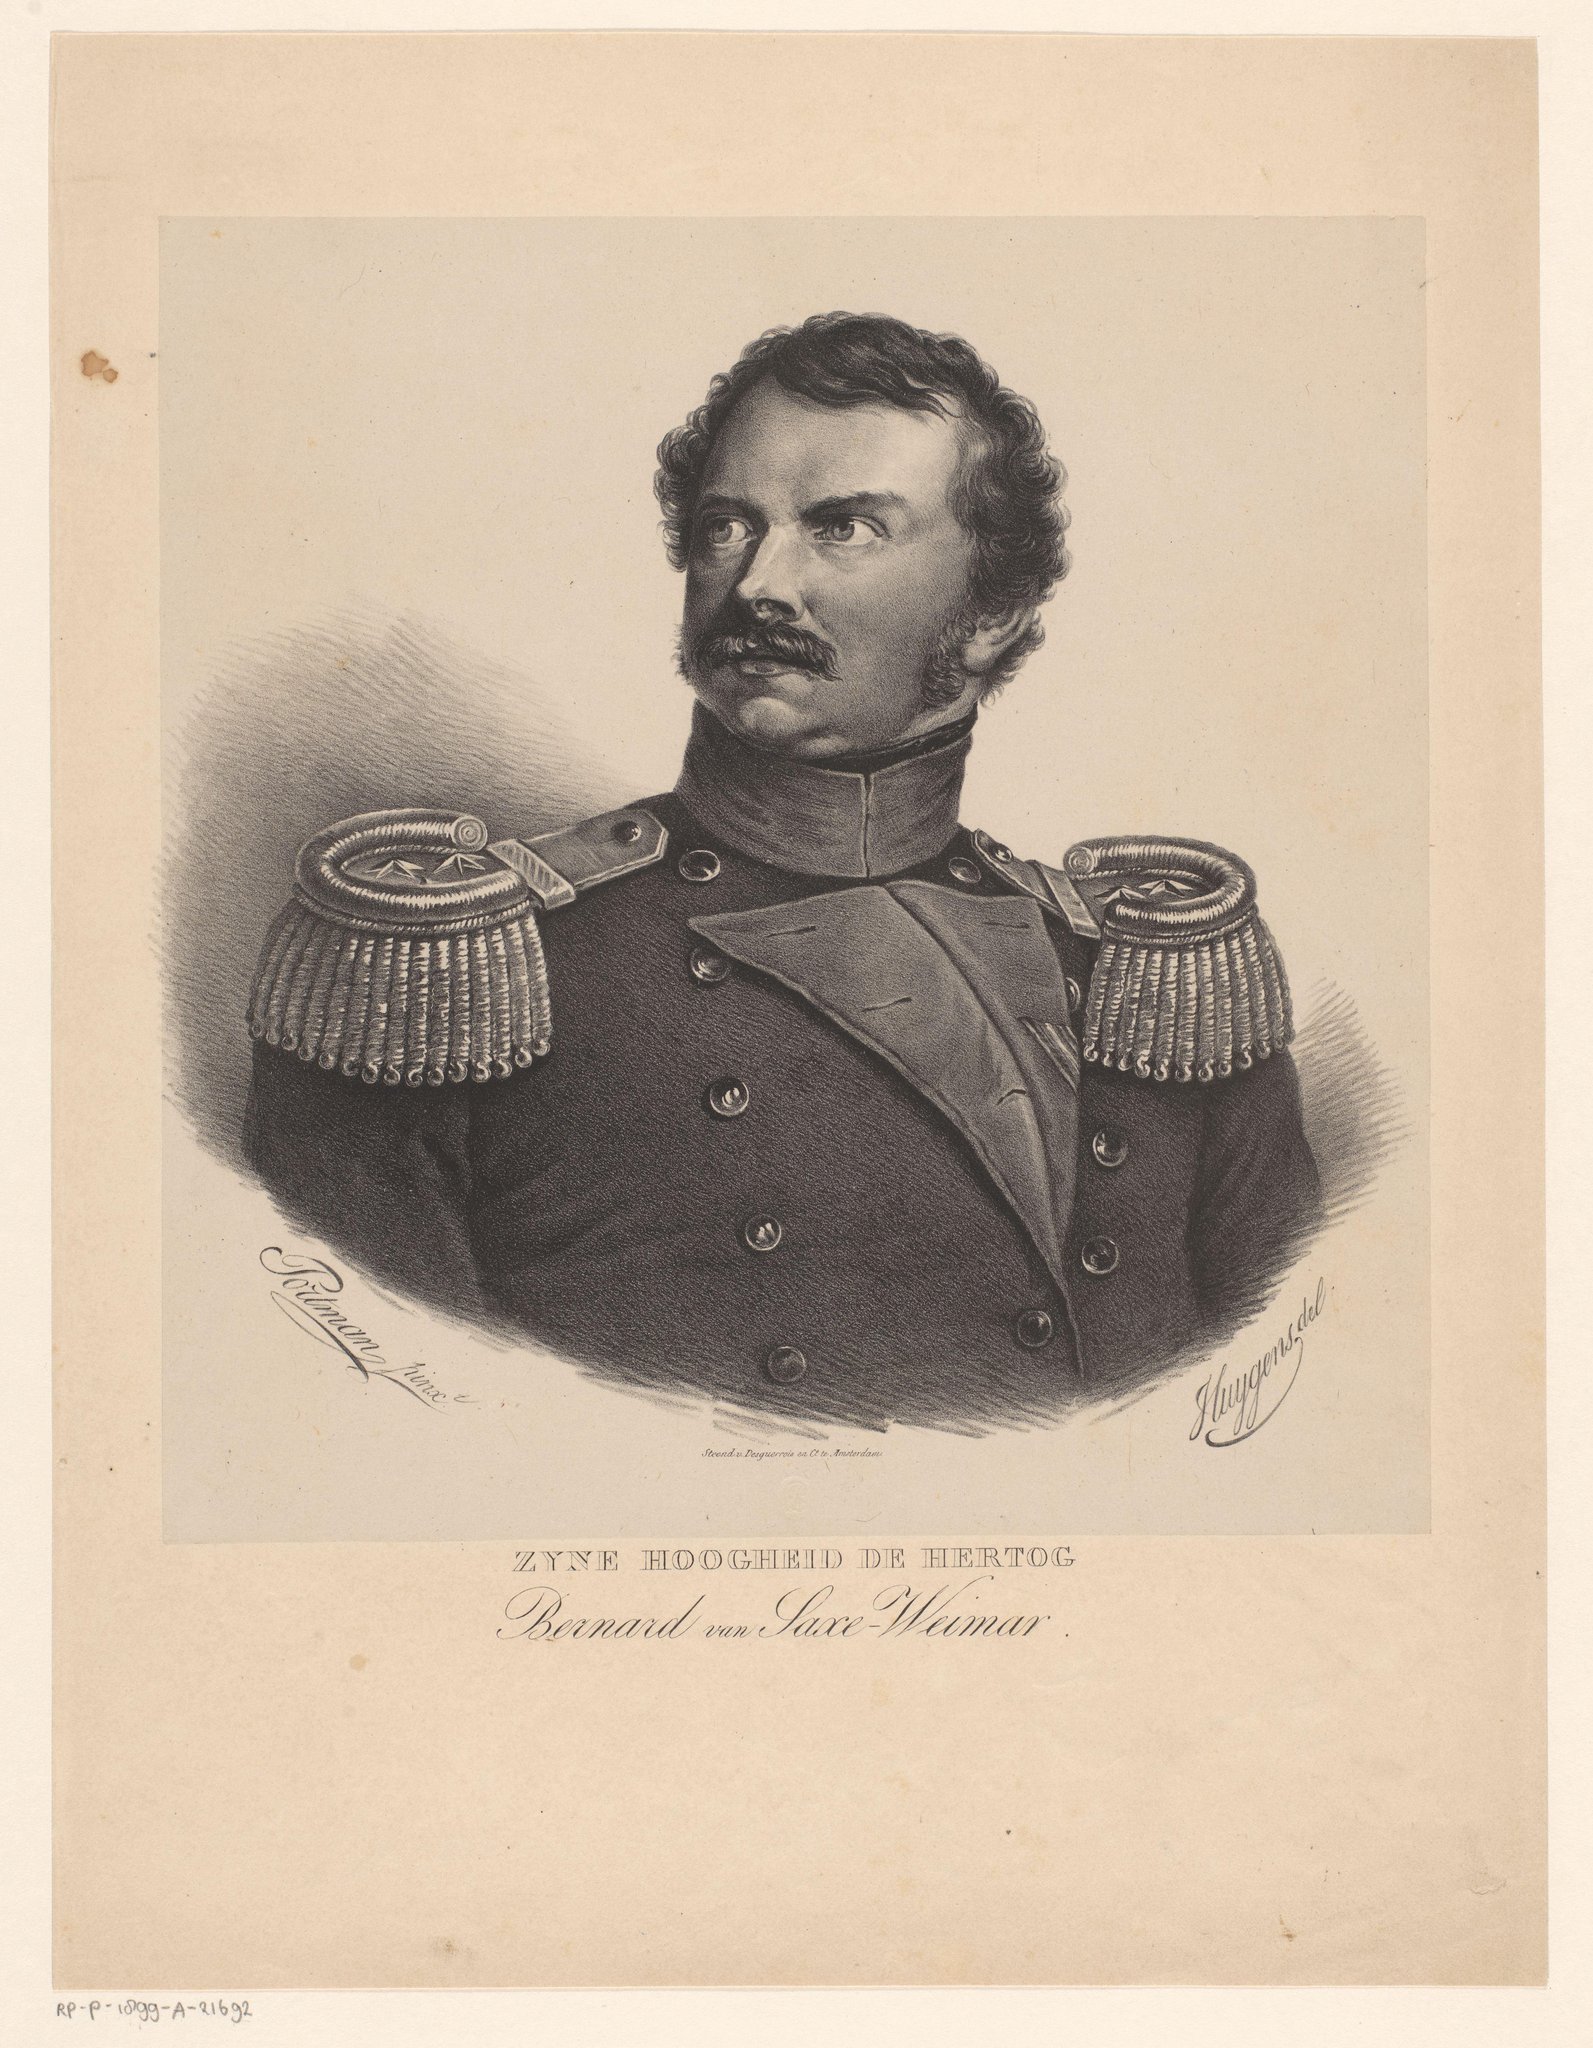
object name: print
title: Portret van Karel Bernard hertog van Saxen-Weimar-Eisenach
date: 1831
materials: paper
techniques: lithograph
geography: amsterdam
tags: head turned to the left, historical persons (+ (full) bust portrait)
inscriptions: collector's mark: Lugt 2228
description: De geportretteerde draagt een militair uniform. Onder het portret zijn naam.